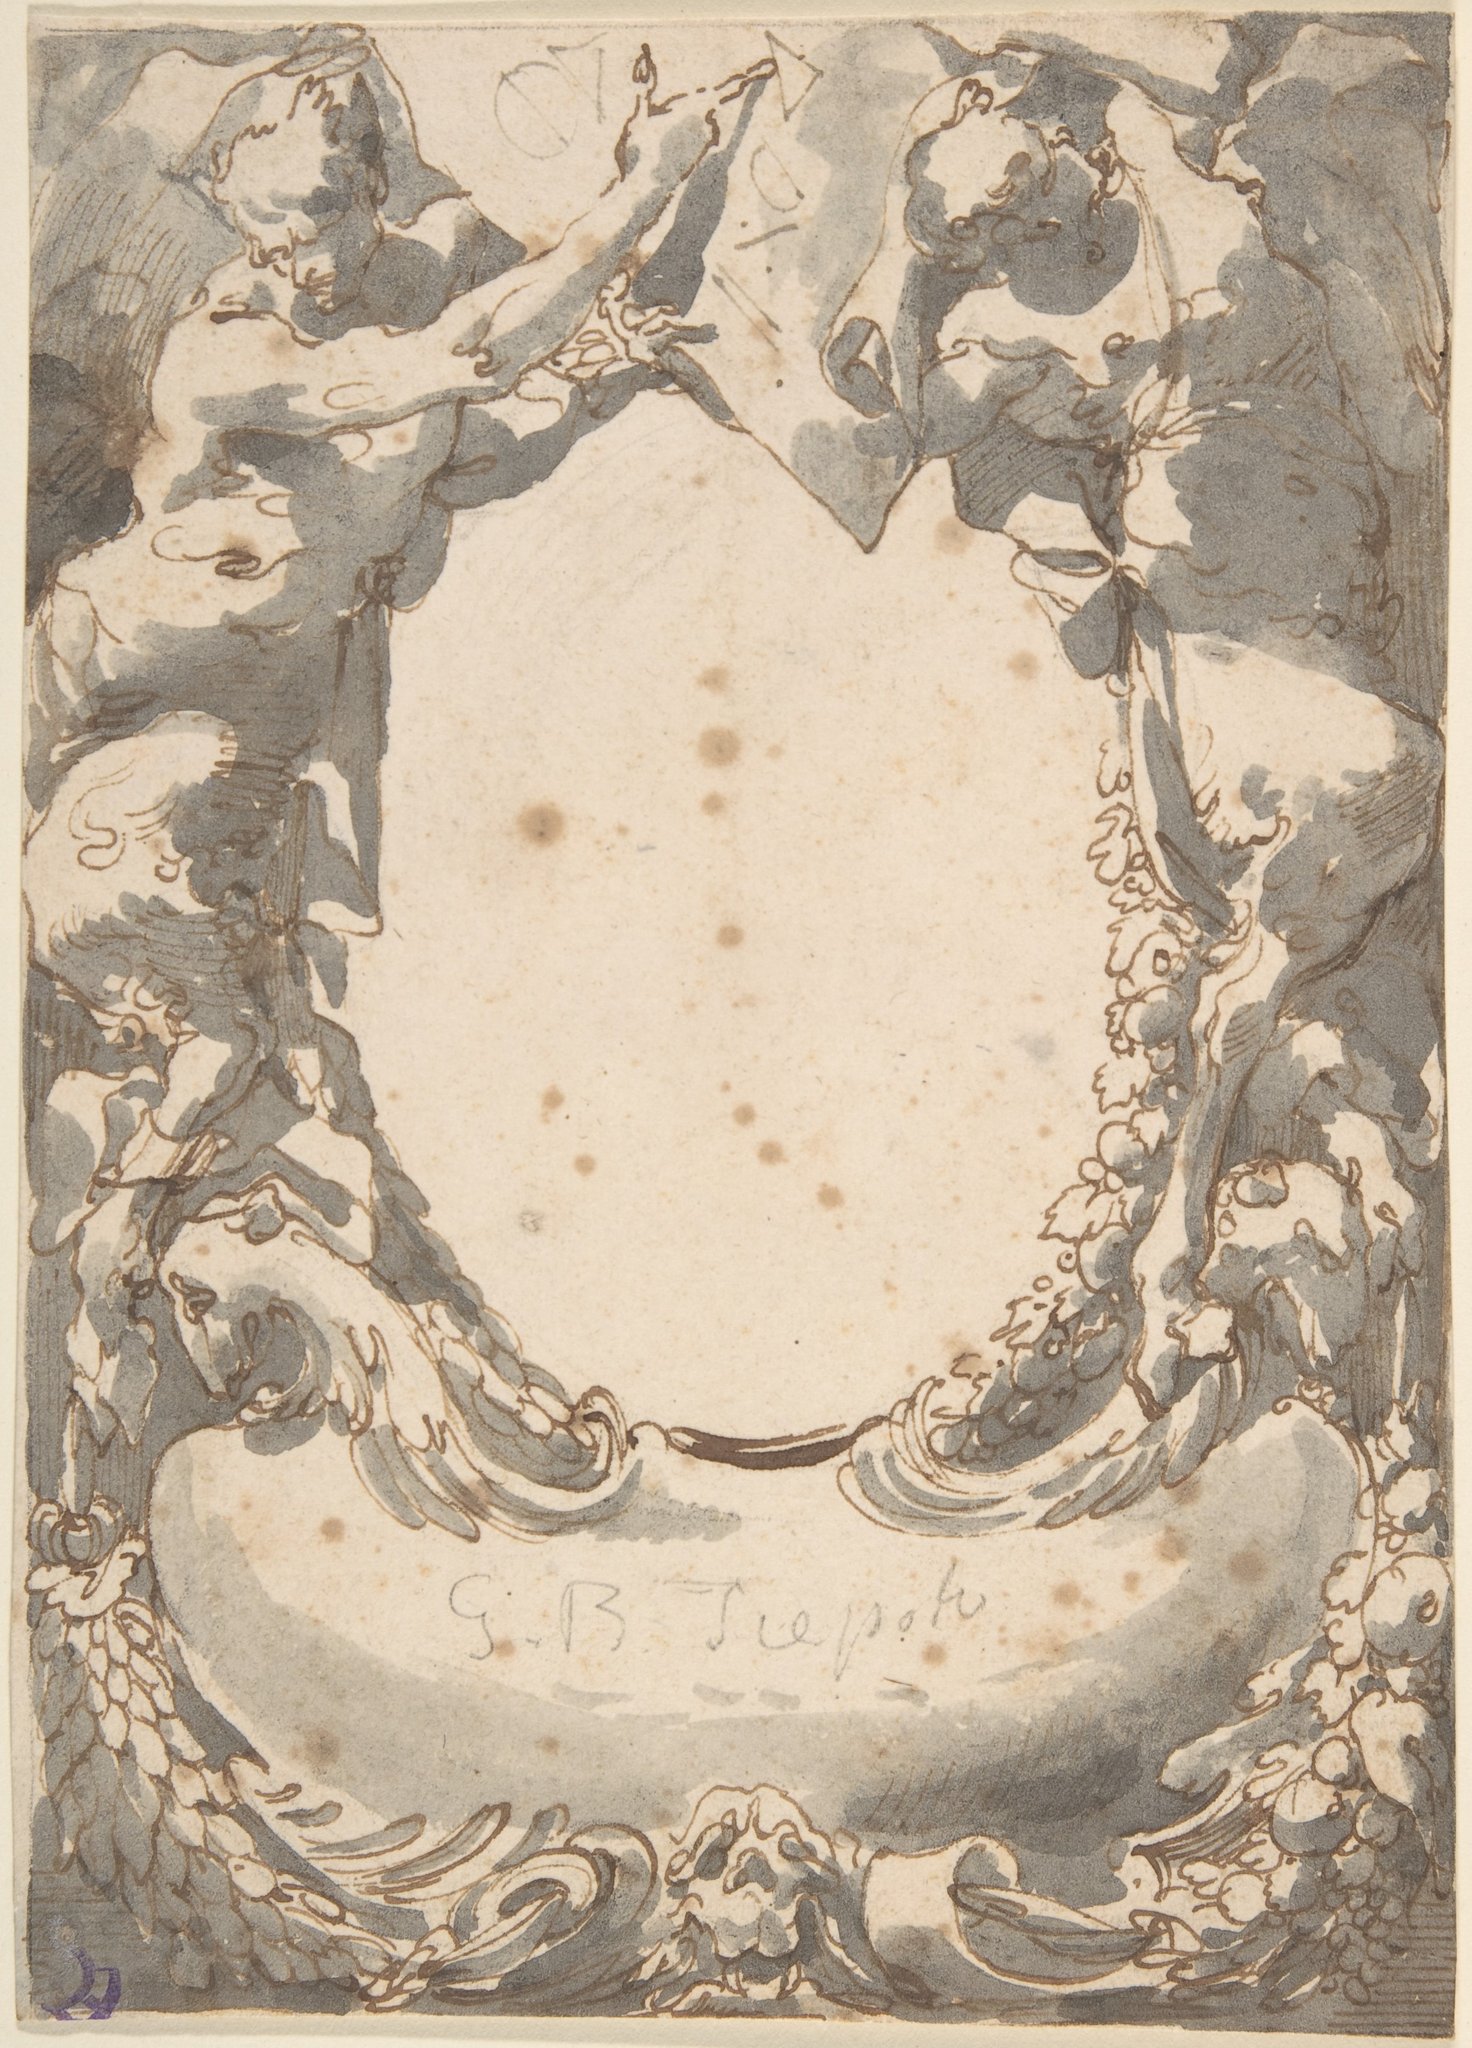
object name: drawing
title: Design for a Double Cartouche flanked by Satyrs (Frontispiece?)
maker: anonymous, italian, venetian, 18th century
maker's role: artist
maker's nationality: italian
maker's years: 1700-1800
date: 1701-1800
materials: ink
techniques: pen, wash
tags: satyrs